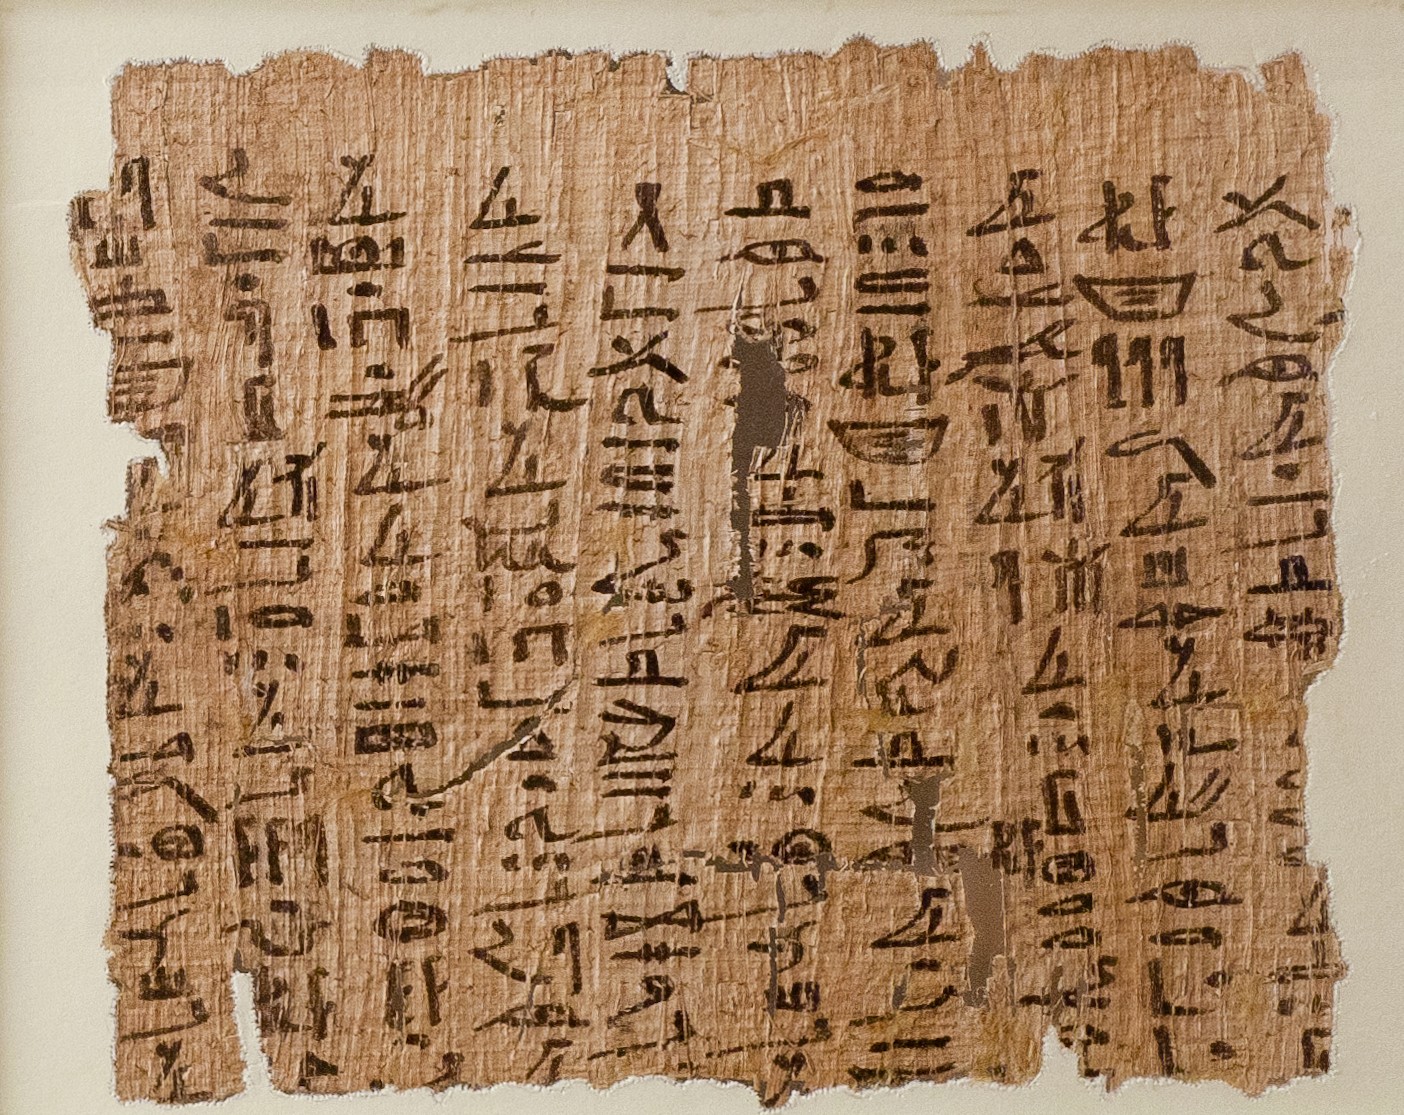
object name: papyrus, harhotep, account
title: Papyrus inscribed with an account and a religious text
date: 1961-1917 BCE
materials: ink, papyrus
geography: egypt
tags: documents,hieratic